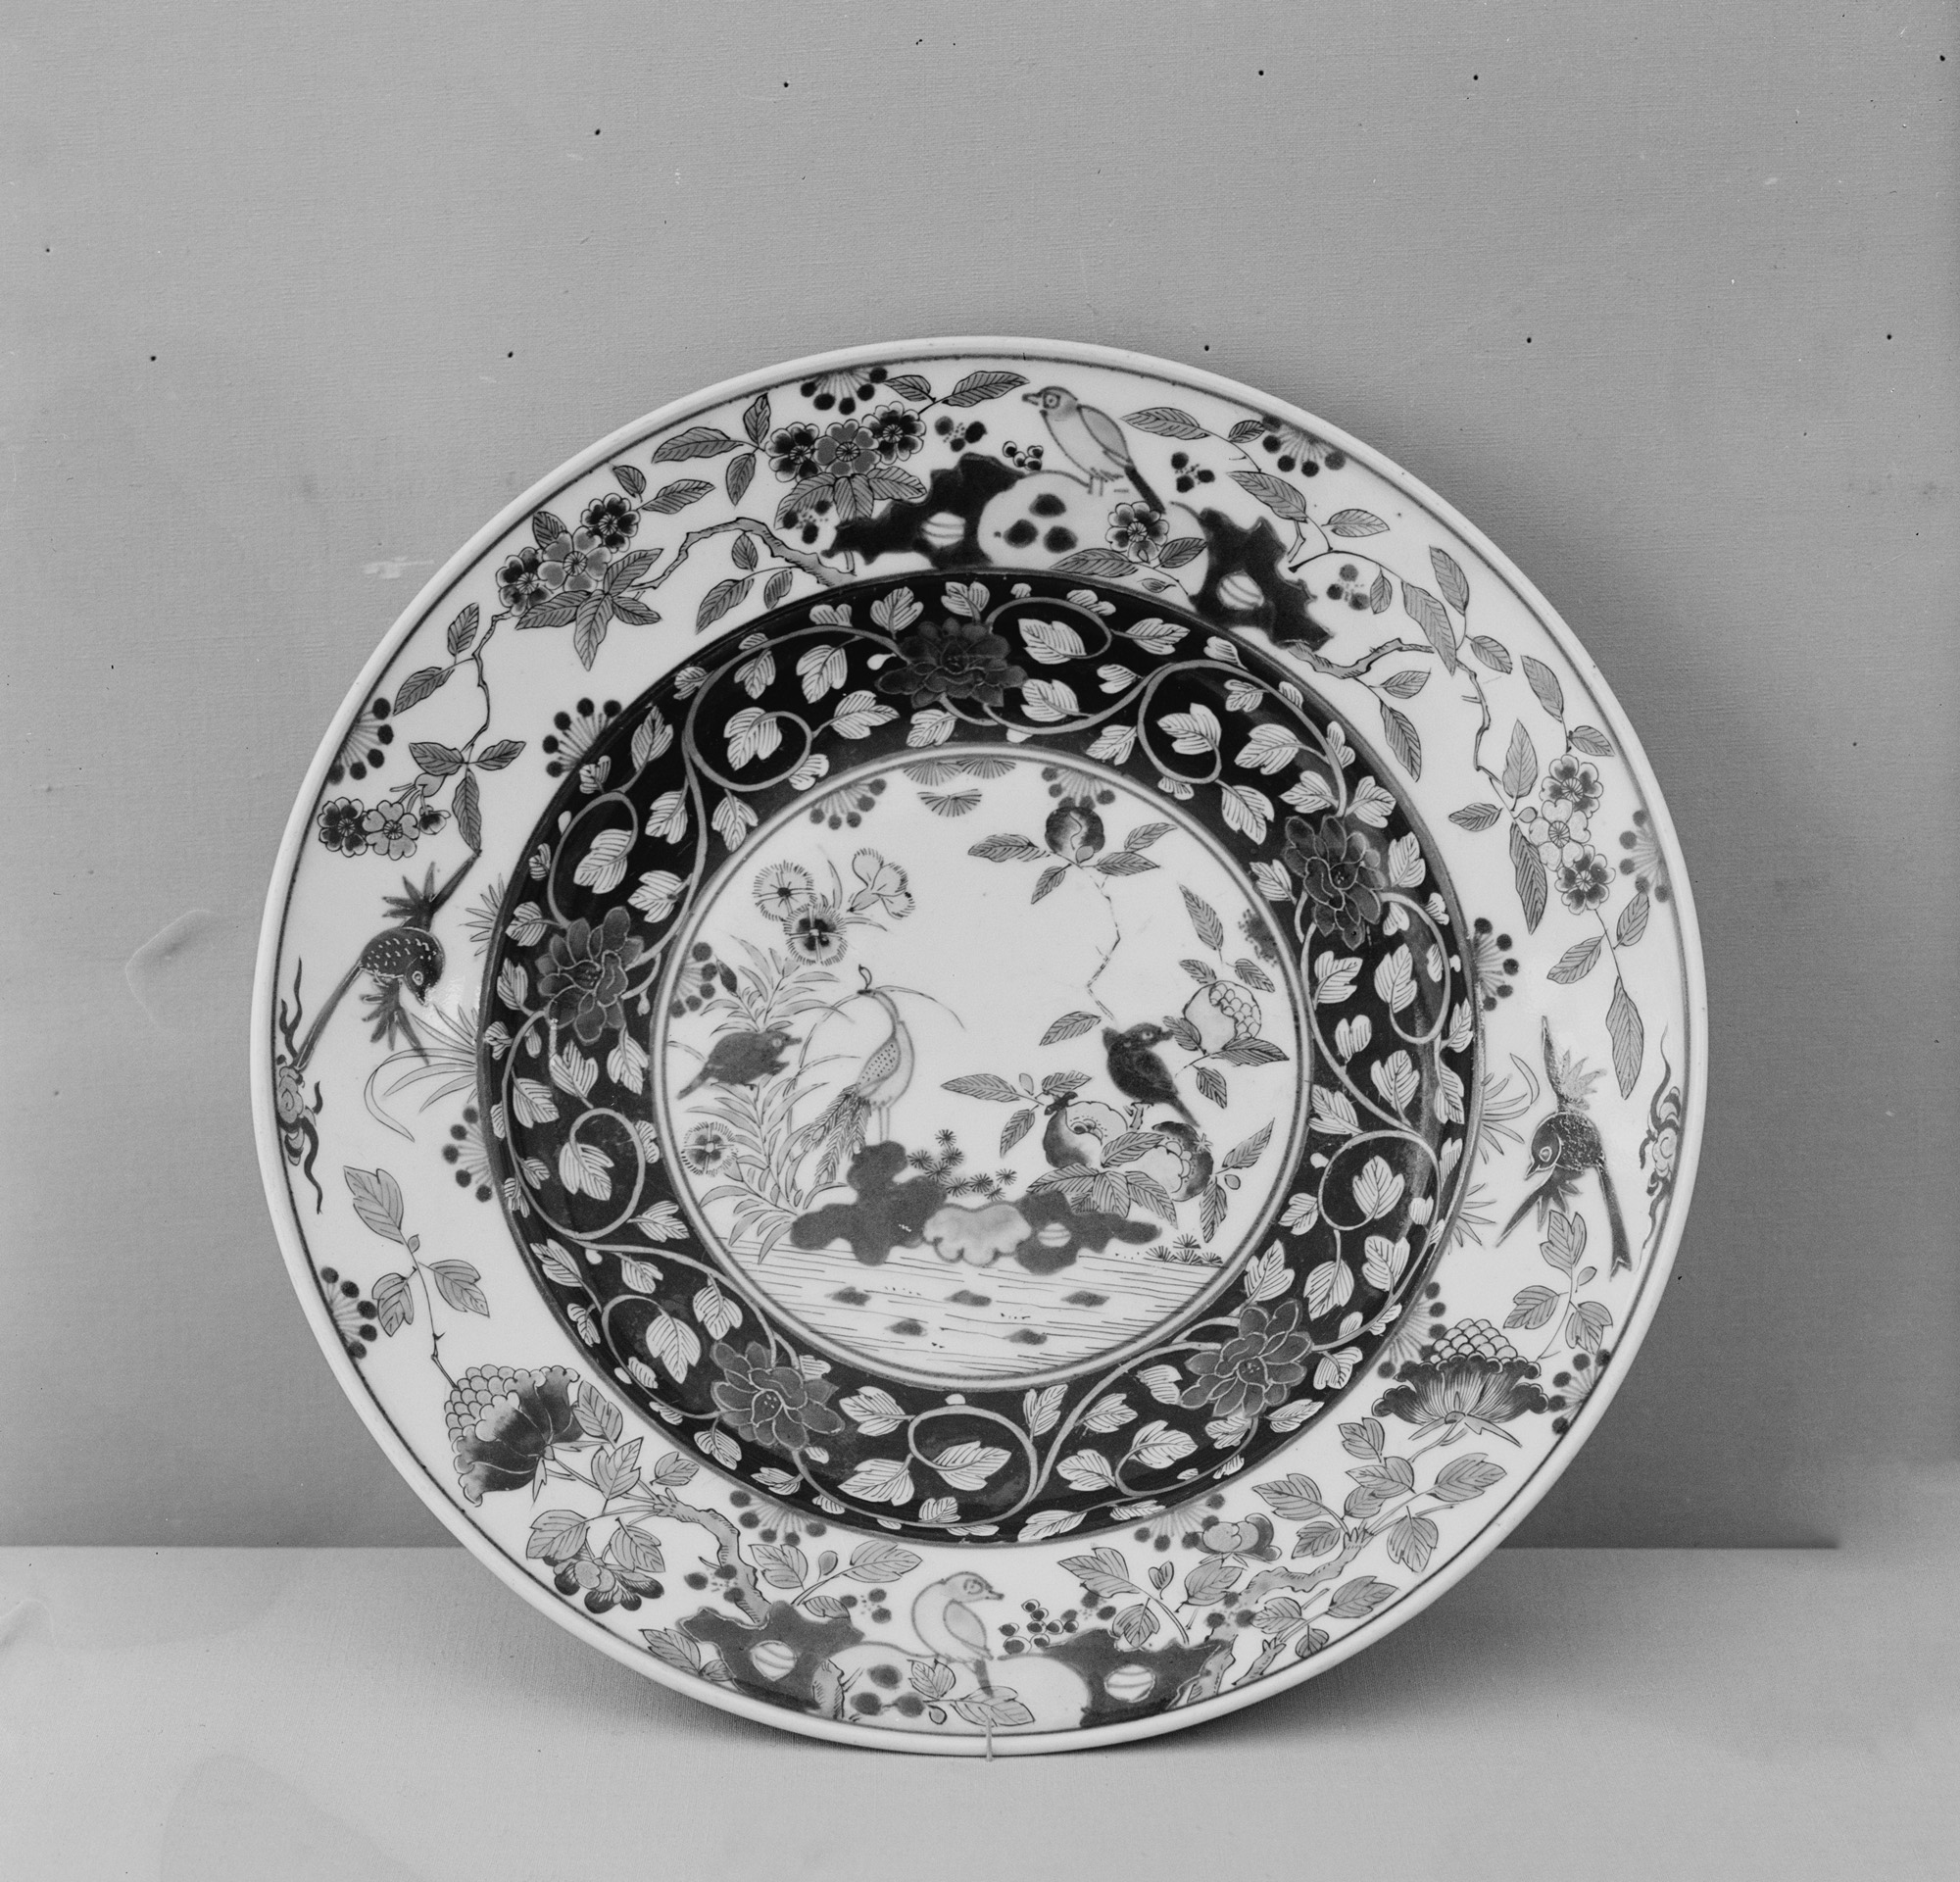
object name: dish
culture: japanese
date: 1700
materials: enamel, glaze, porcelain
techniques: polychrome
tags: birds,flowers